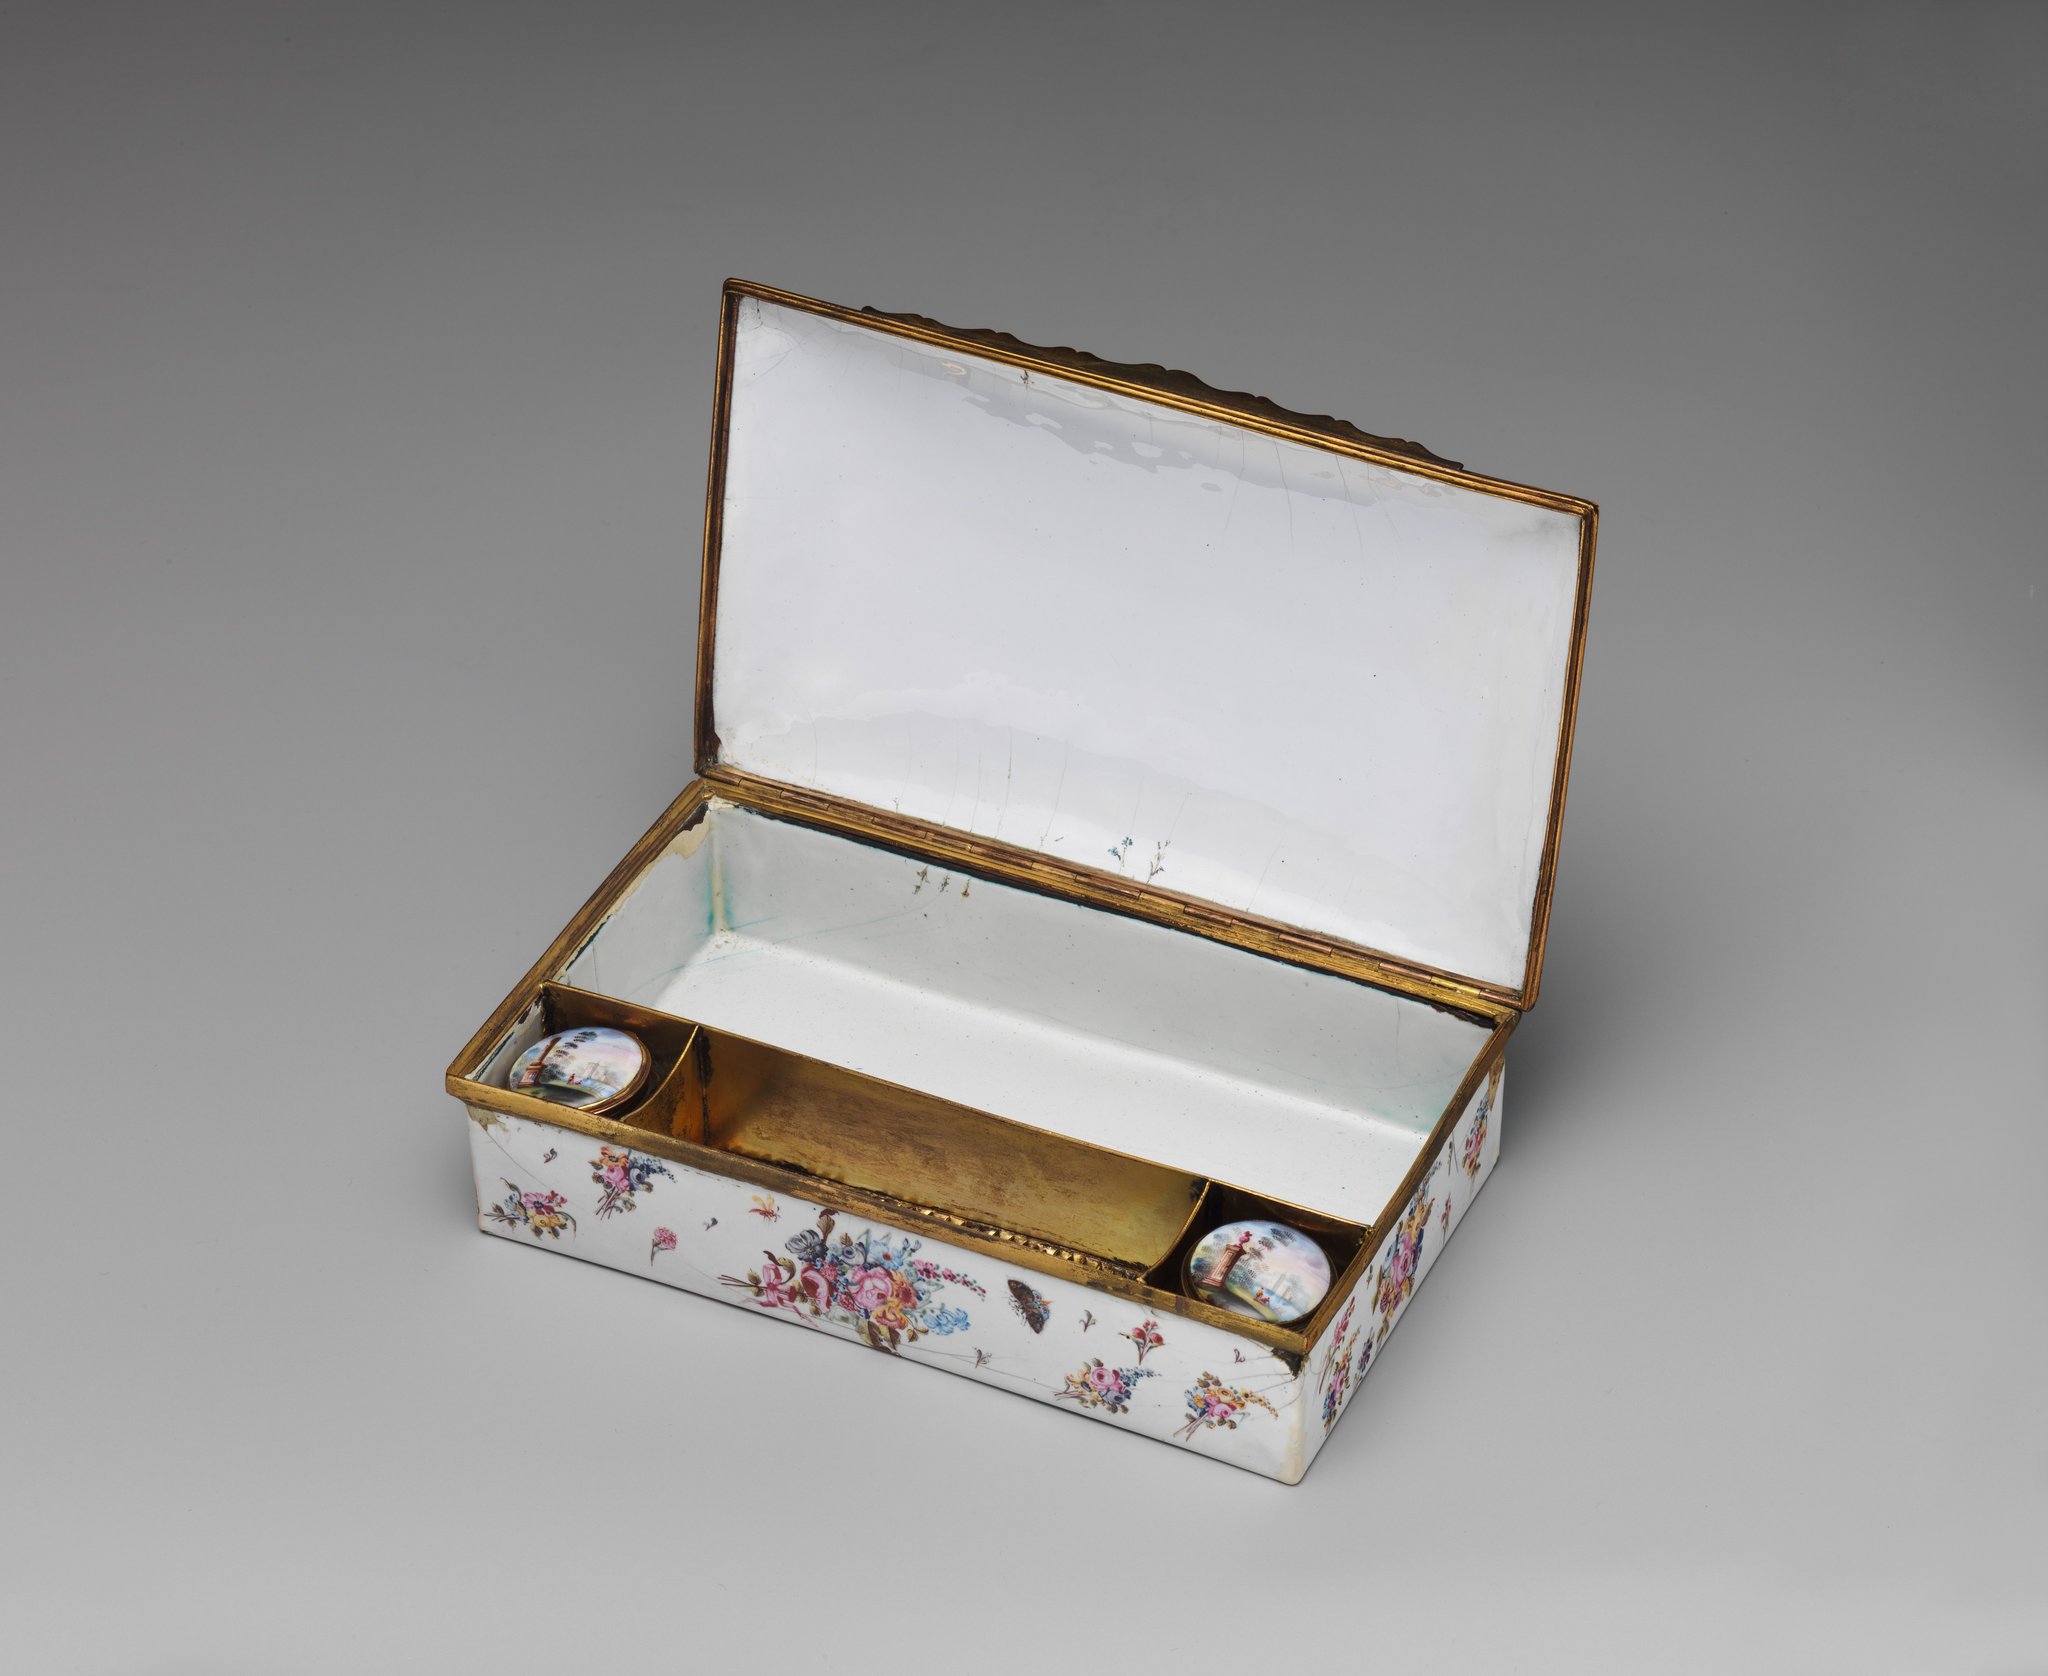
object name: pouncepot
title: Pouncepot (part of a set)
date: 1750-1760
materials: copper, copper gilt, glass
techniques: enamel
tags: men,butterflies,flowers